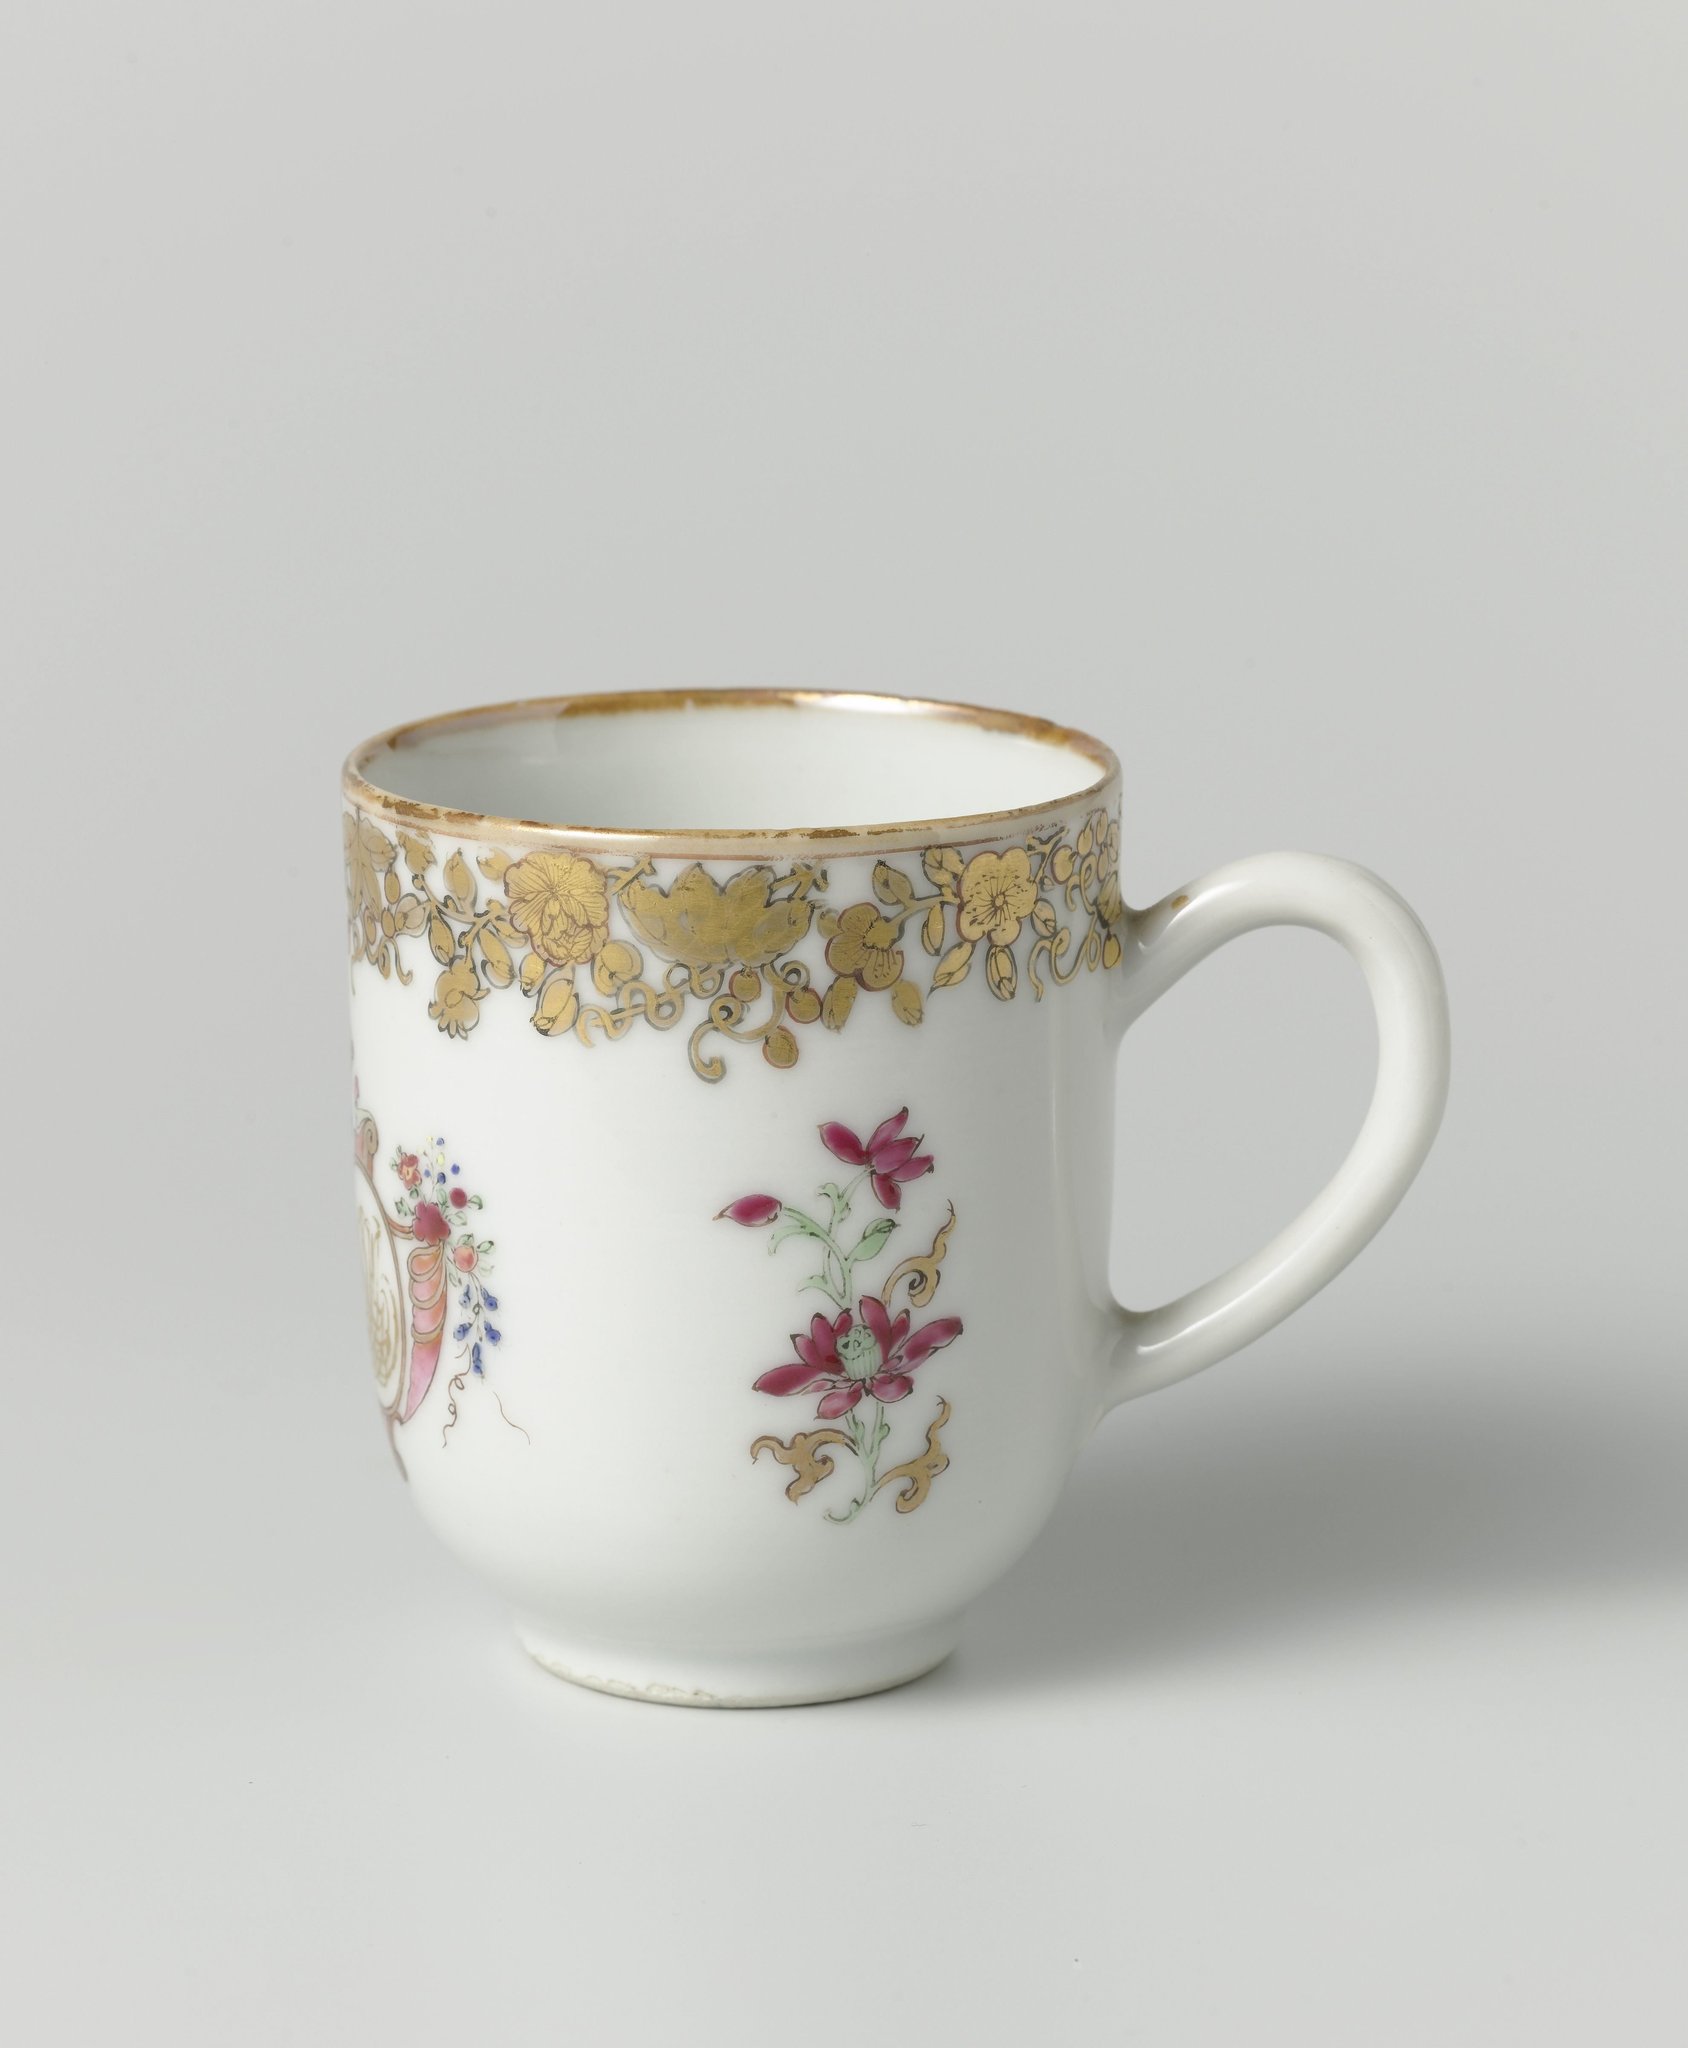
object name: oorkop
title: Cup with handle from the 'Swellengrebel service' with a double crowned monogram and a border with floral scrolls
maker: Anonymous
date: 1740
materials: glaze, gold, paint, porcelain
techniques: firing, gilding, turning, vitrification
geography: china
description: De monogrammen 'MVA' en 'CHTD' staan voor Maurits van Aerden (1694-1746) en Constantia Helena ten Damme (1694-1772), getrouwd in 1716. Het servies is waarschijnlijk besteld ter ere van hun vijfentwingtigjarig huwelijksjubileum in 1741. (Campen, Jan van & Hartkamp-Jonxis, Ebeltje, Aziatische weelde : VOC-kunst in het Rijksmuseum, Zutphen 2011, p. 78)